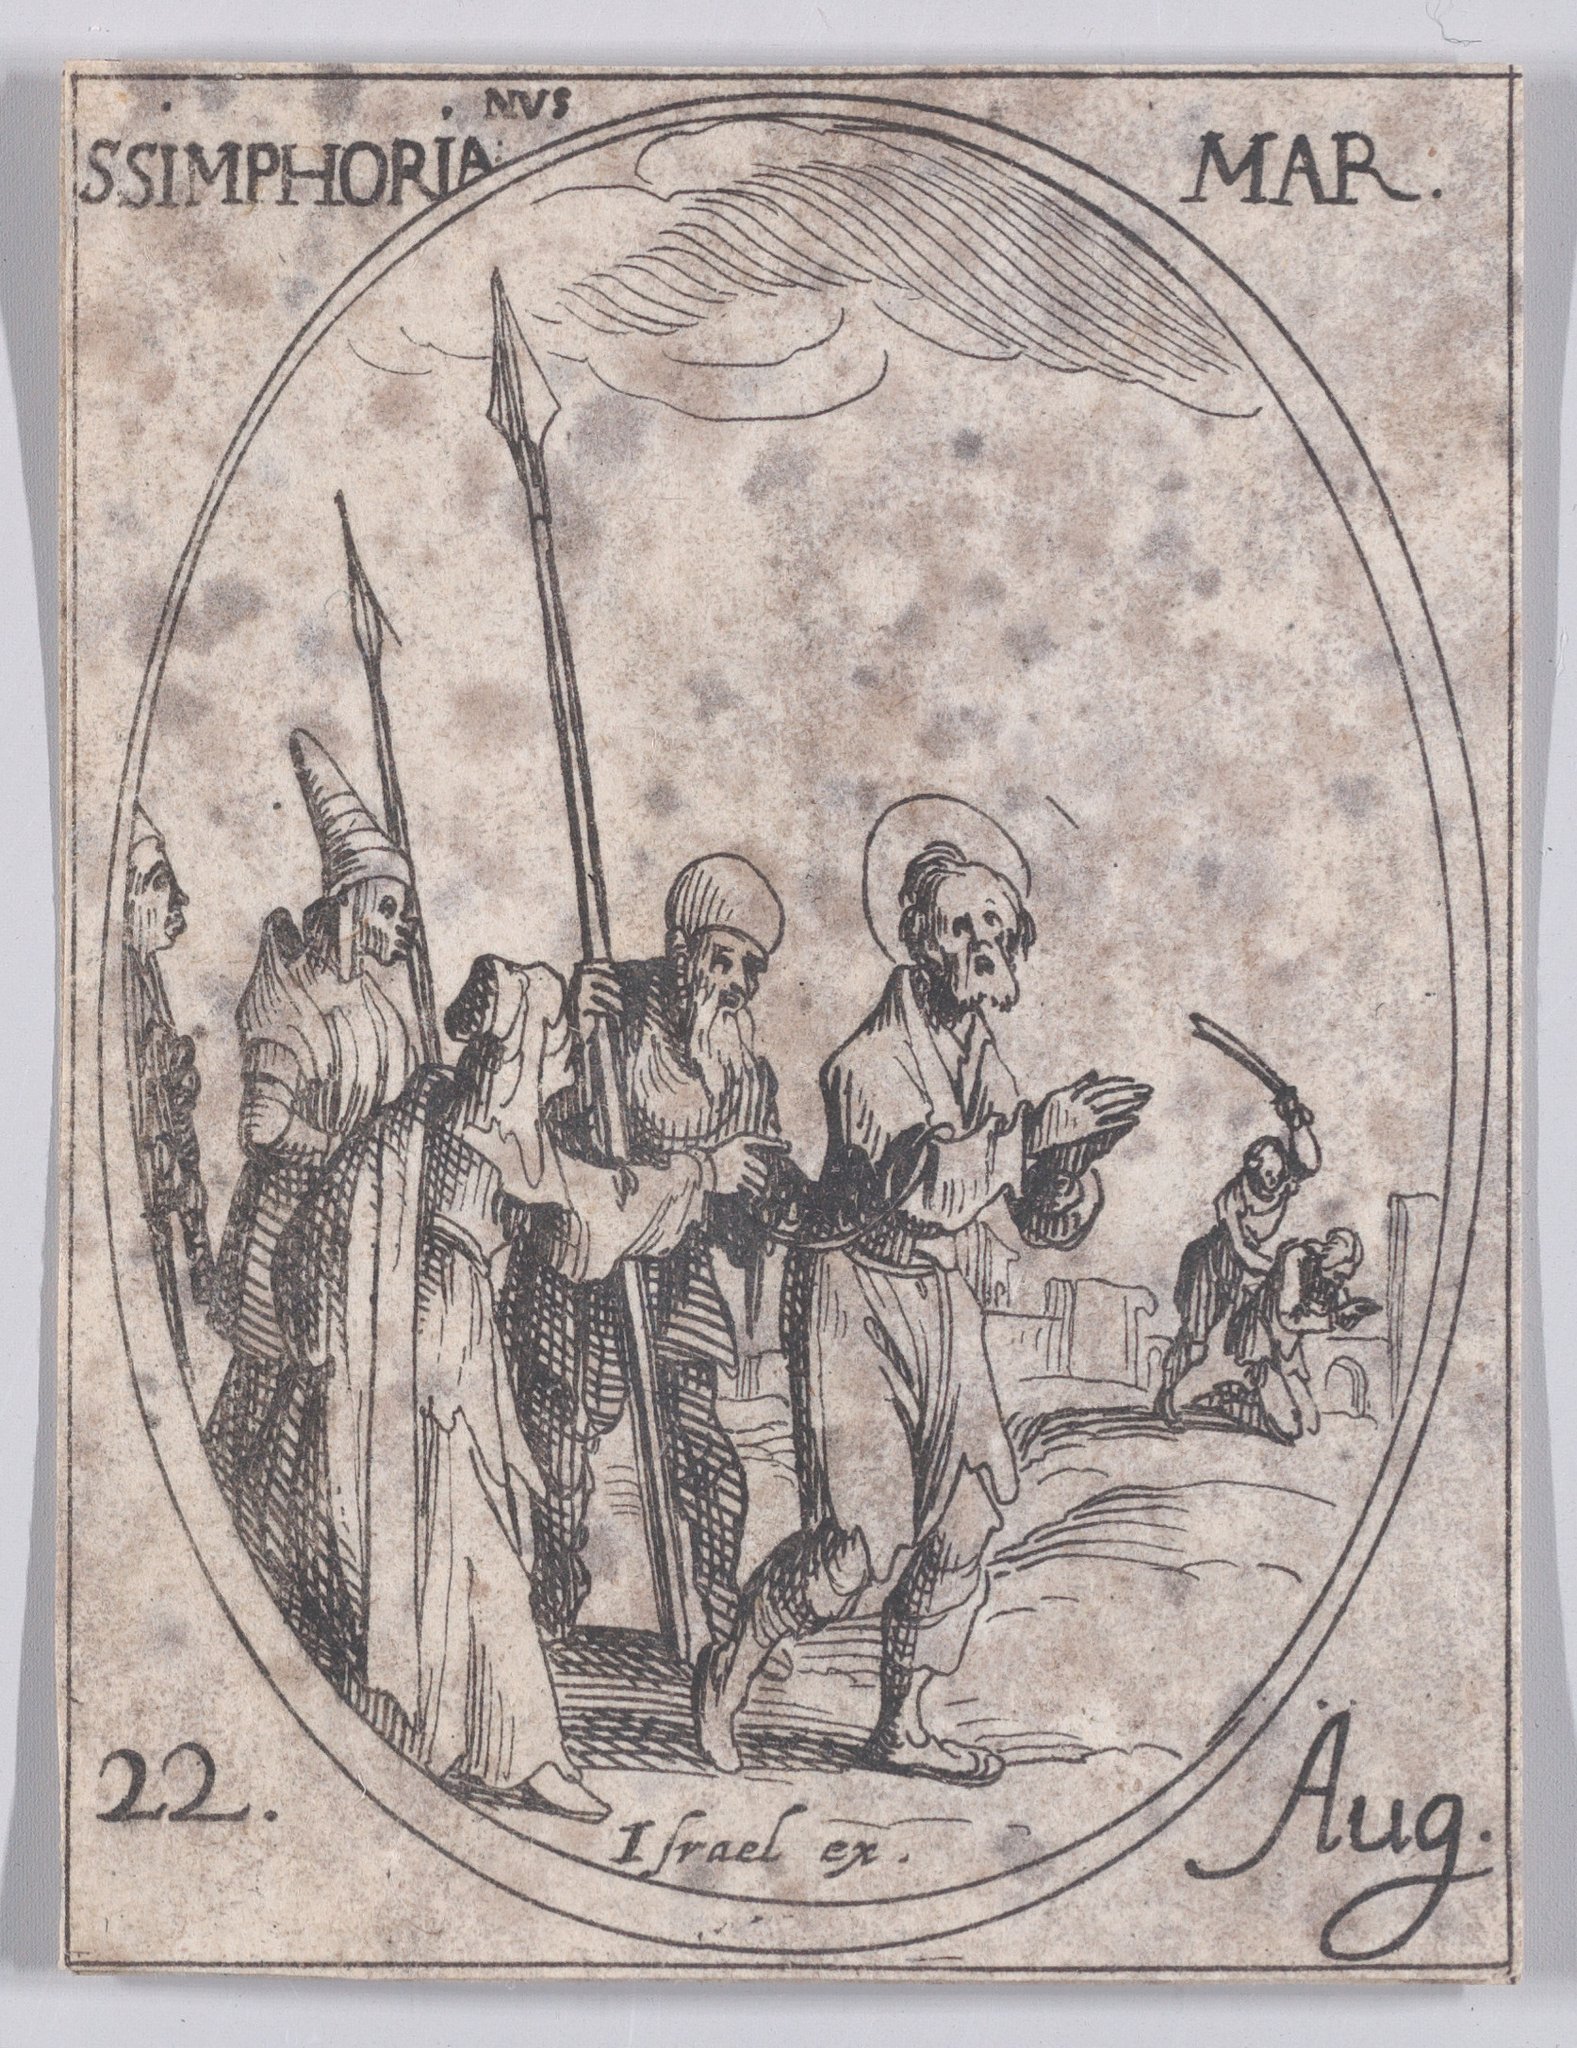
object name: print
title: S. Symphorien, martyr (St. Symphorian, Martyr), August 22nd, from "Les Images De Tous Les Saincts et Saintes de L'Année" (Images of All of the Saints and Religious Events of the Year)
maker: jacques callot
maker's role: artist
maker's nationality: french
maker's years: 1592-1635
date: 1636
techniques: etching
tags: men,saints